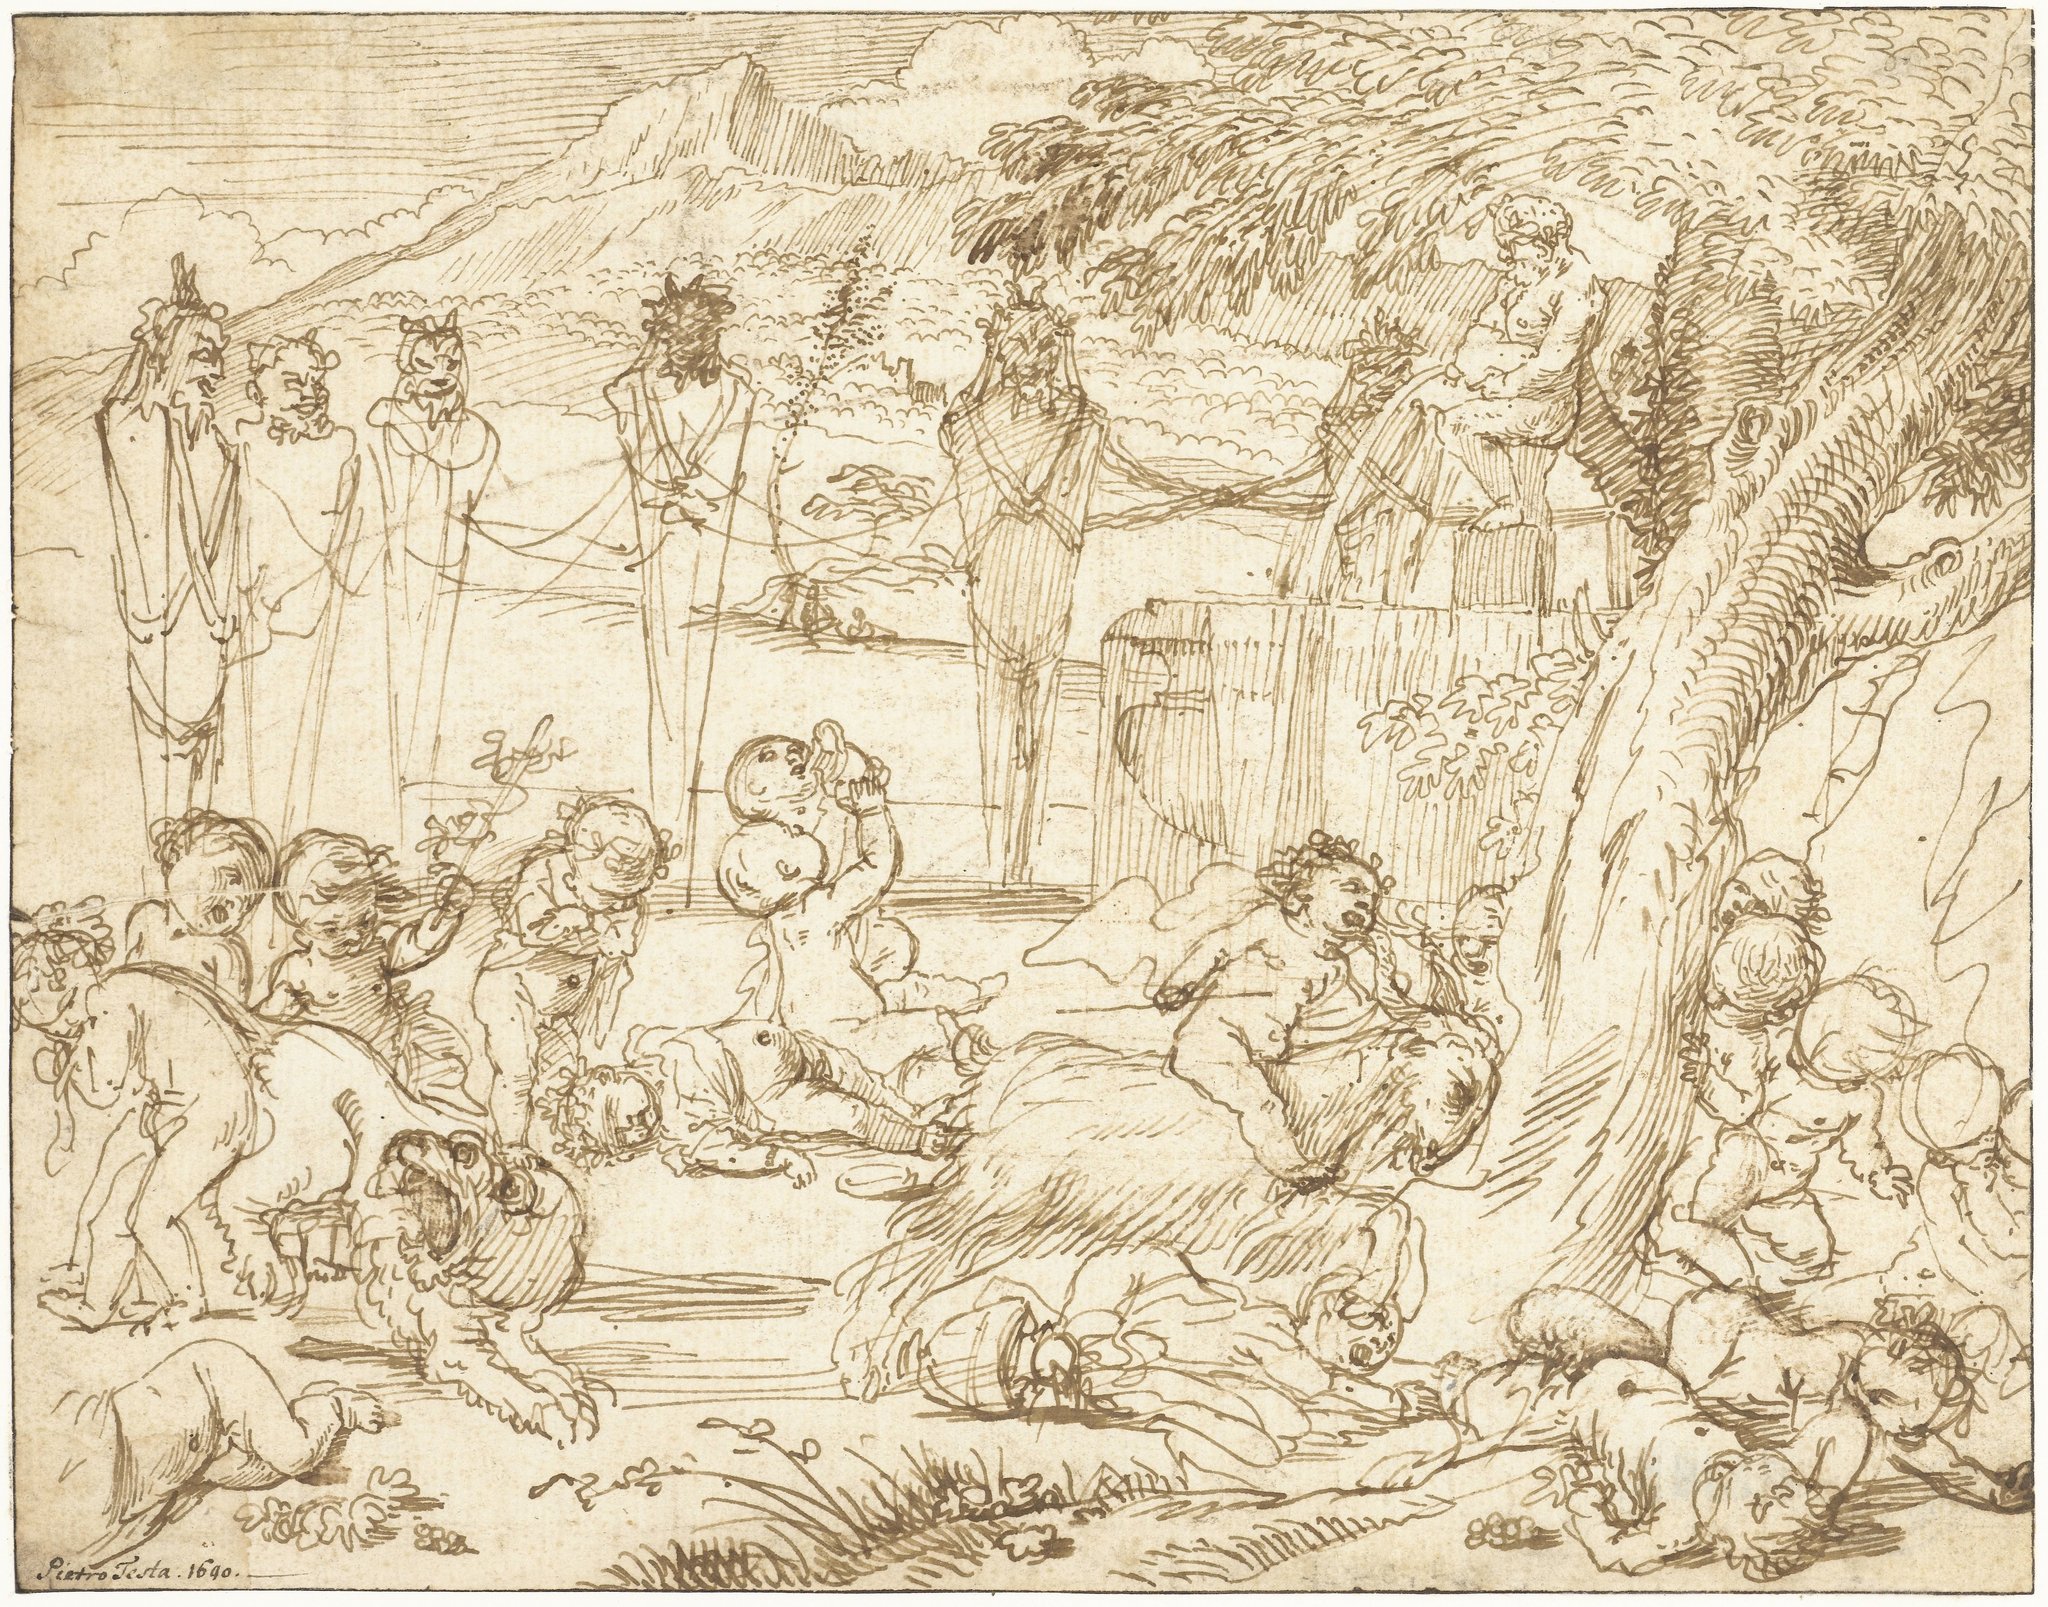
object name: drawing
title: Bacchanaal van putti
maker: pietro testa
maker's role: draughtsman, painter, print maker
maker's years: 1611-1650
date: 1640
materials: ink, paper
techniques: pen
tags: children's bacchanal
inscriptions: date